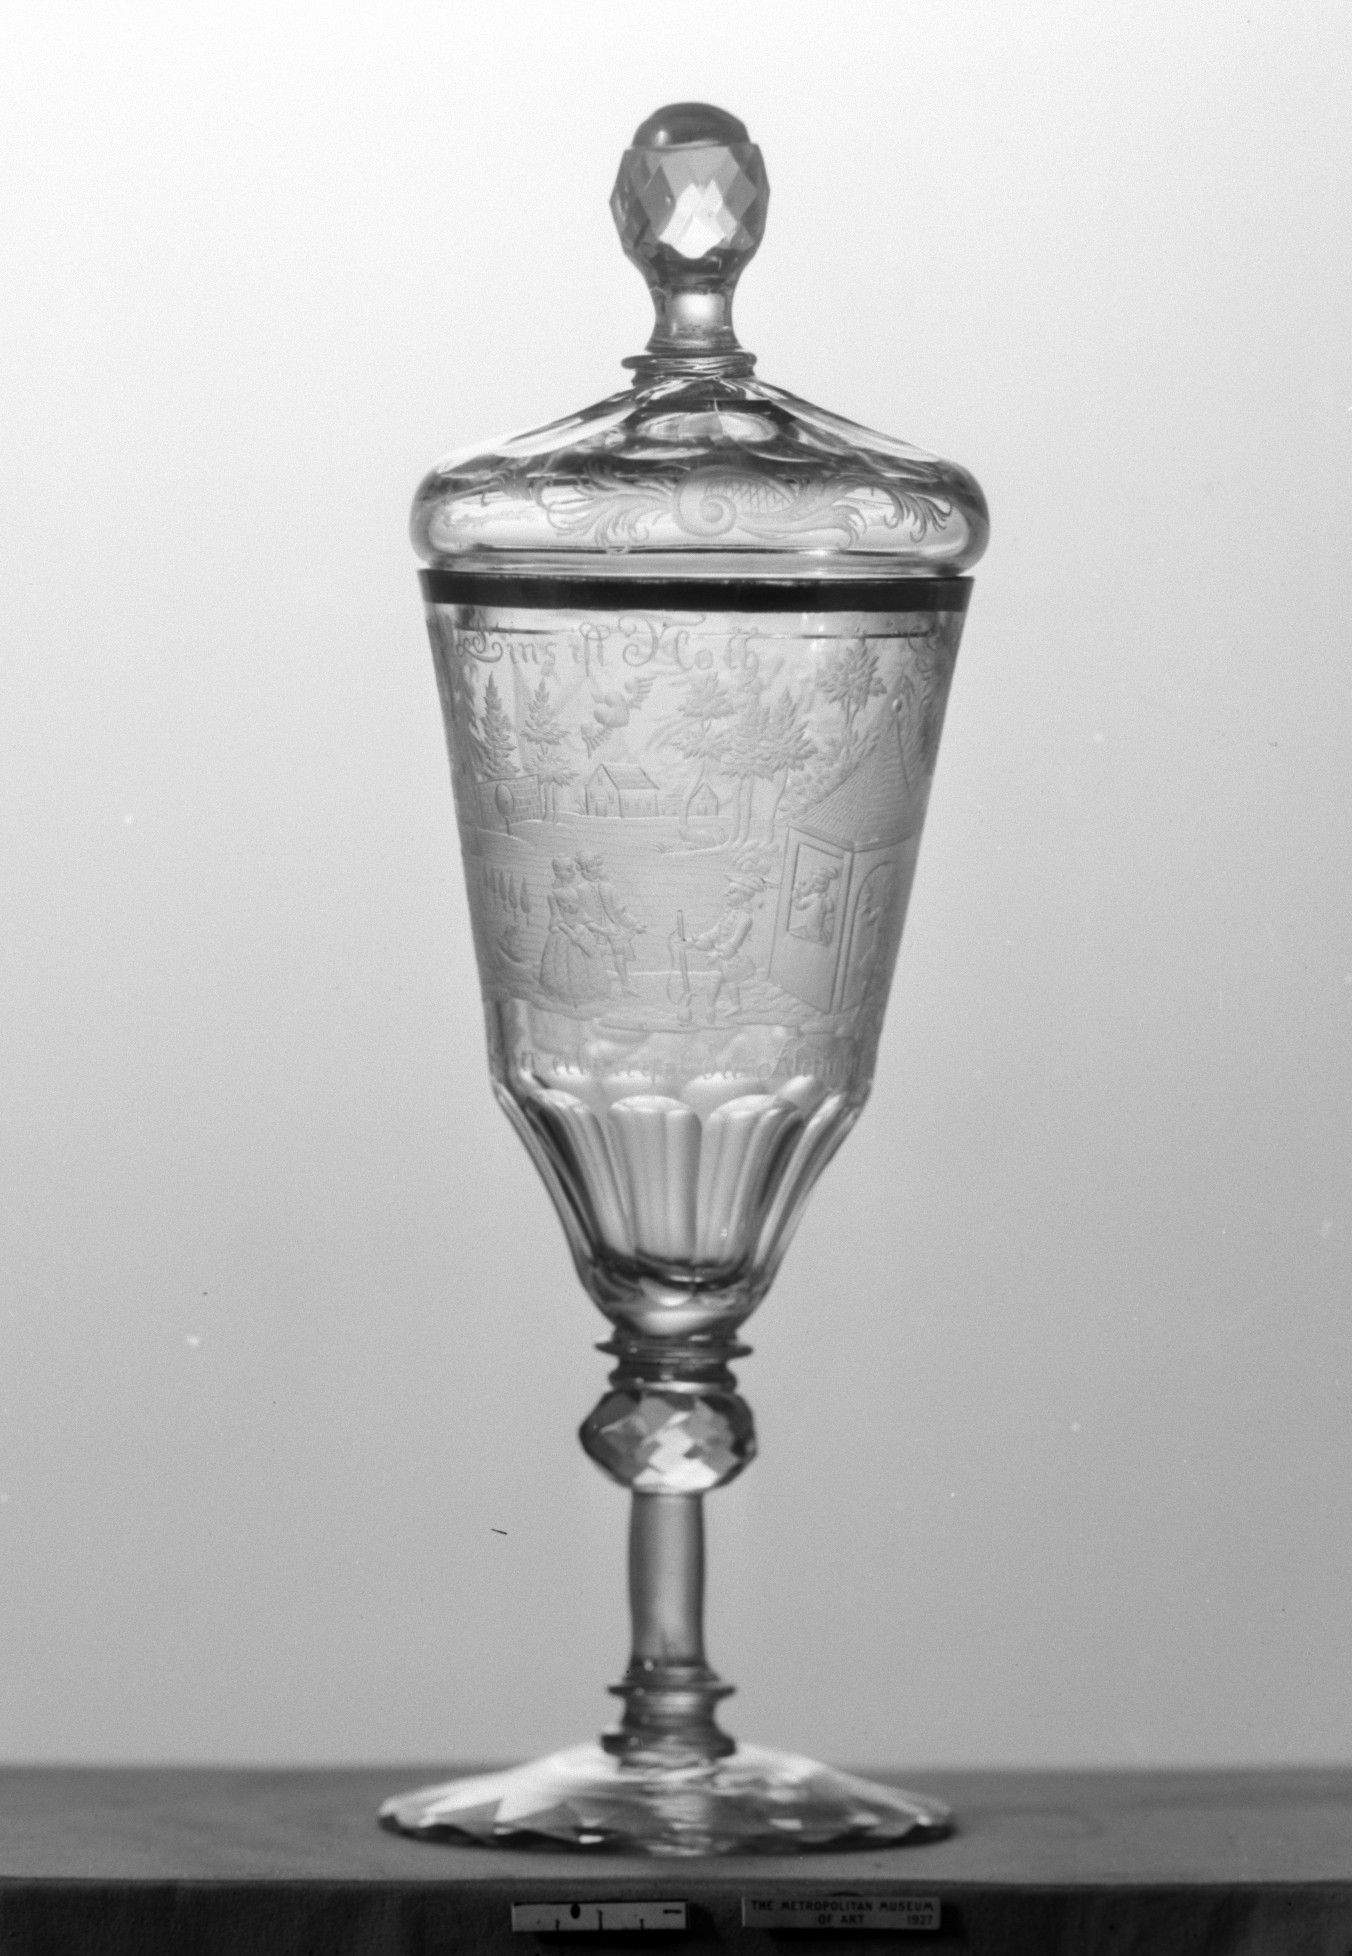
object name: standing cup with cover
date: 1764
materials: glass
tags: men,women,trees